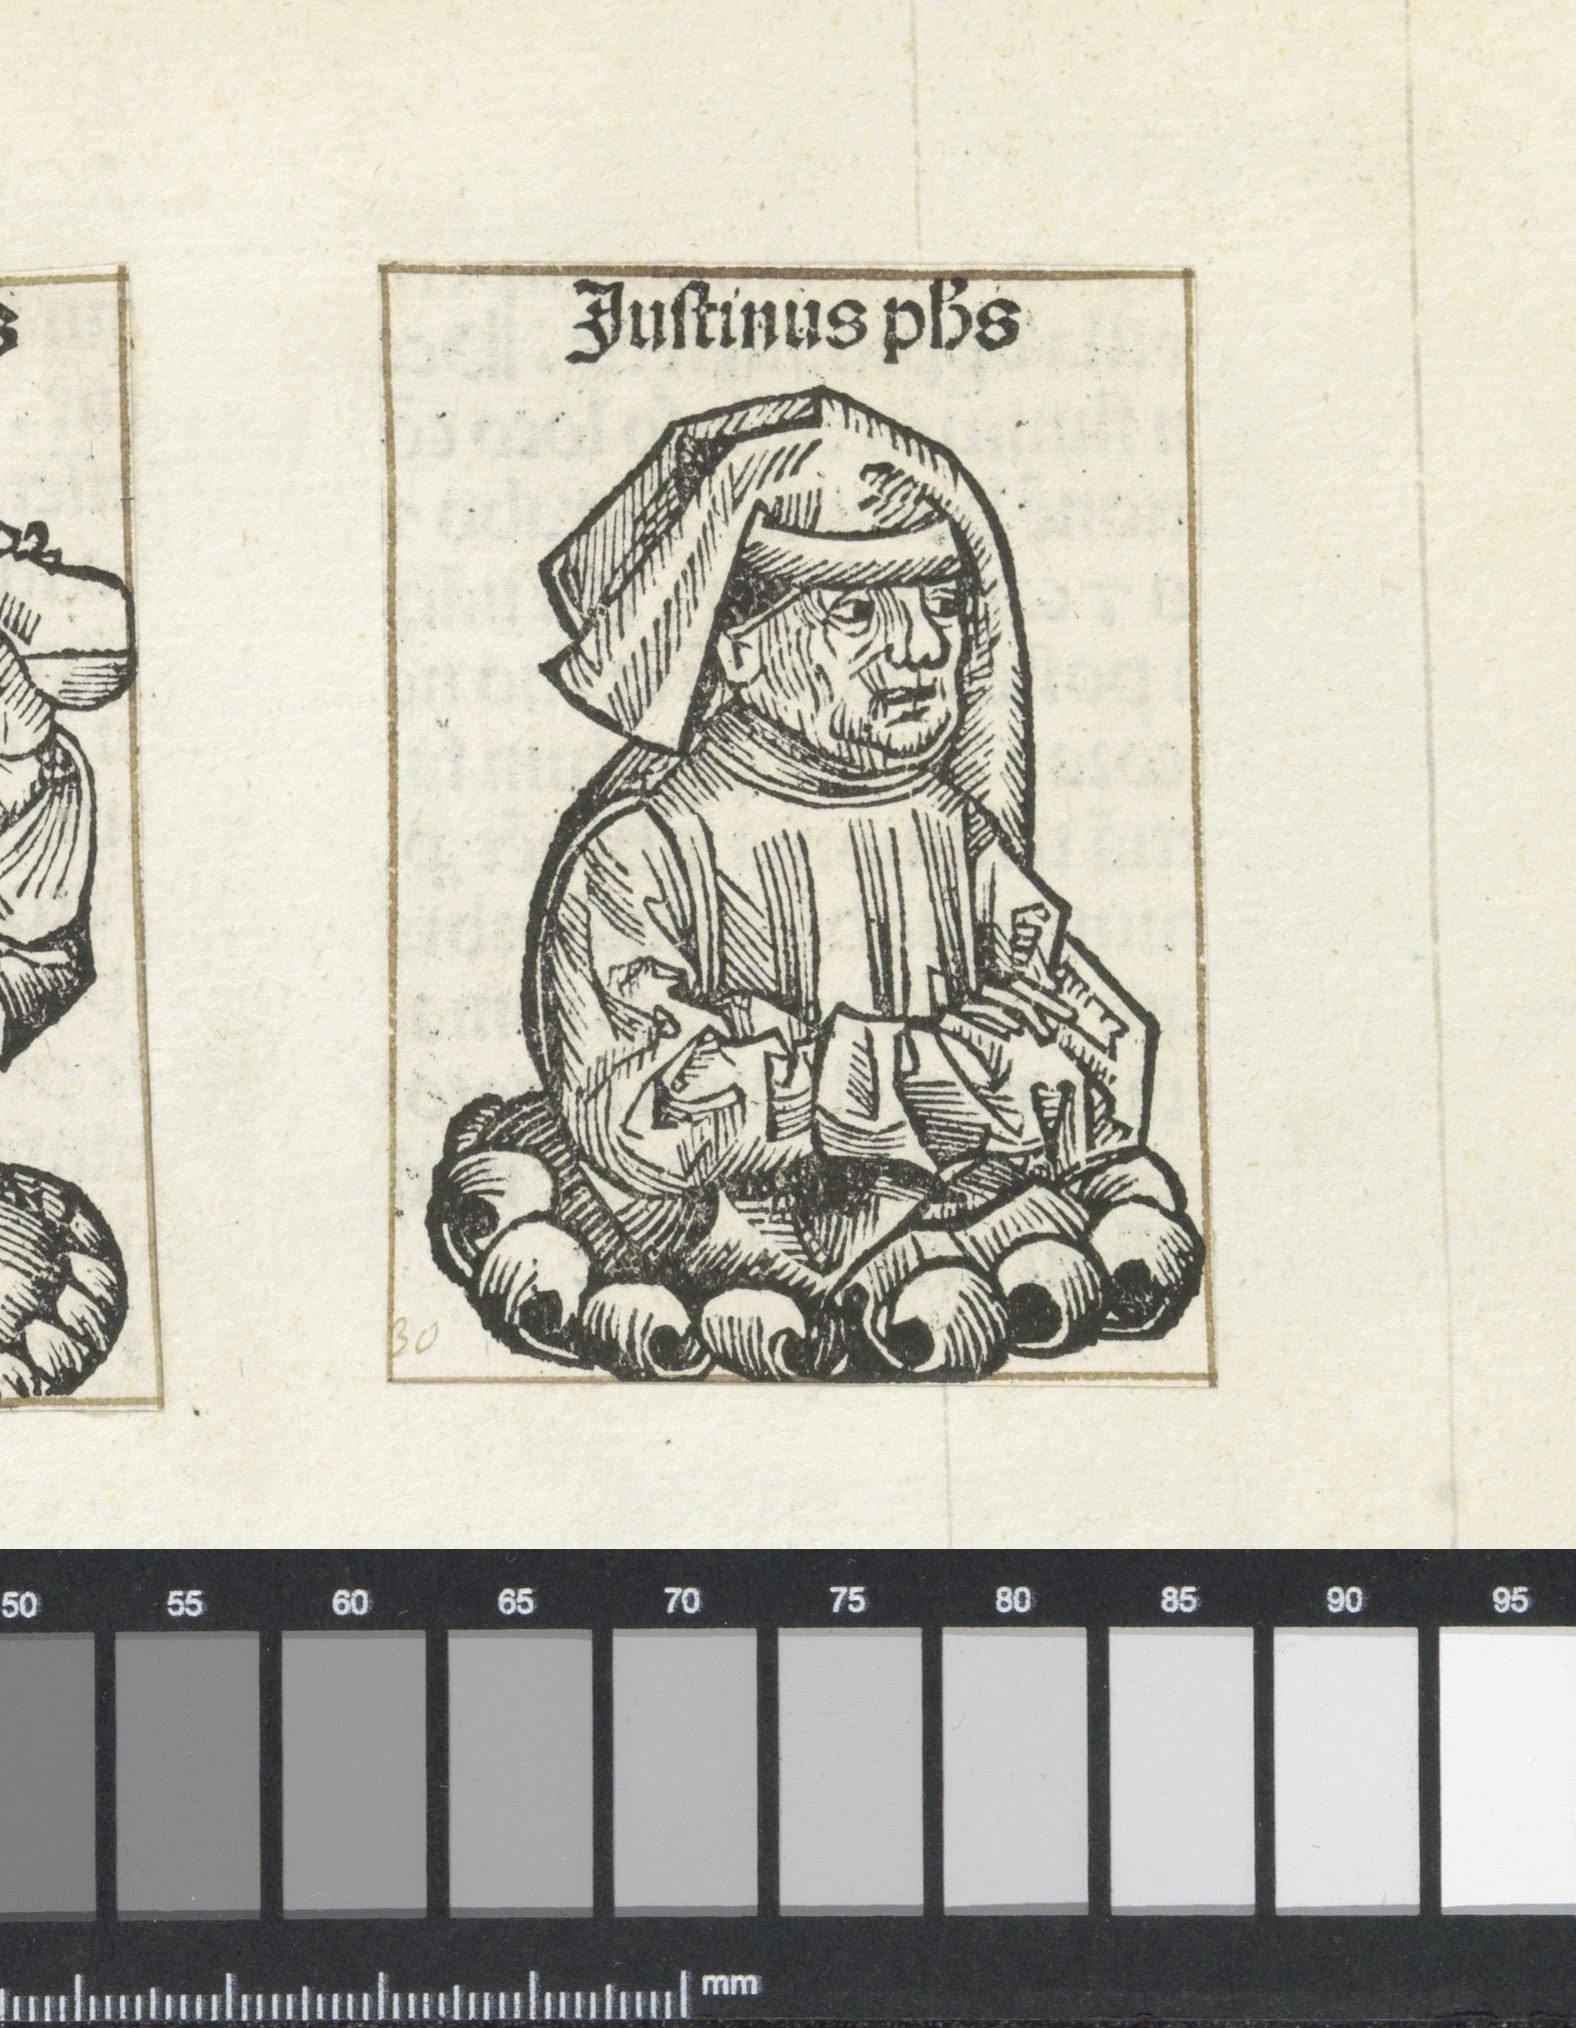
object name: book illustration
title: Justinus ph[ilosophu]s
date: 1493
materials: paper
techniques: letterpress printing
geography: nuremberg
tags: male persons from classical history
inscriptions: inscription: ‘30’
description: Een bloemkelk met een man. Hij draagt een kaproen en heeft zijn handen in zijn mouwen gestoken. De tekst identificeert hem als de filosoof Justinus, bijgenaamd de Martelaar. De prent maakt deel uit van een album.